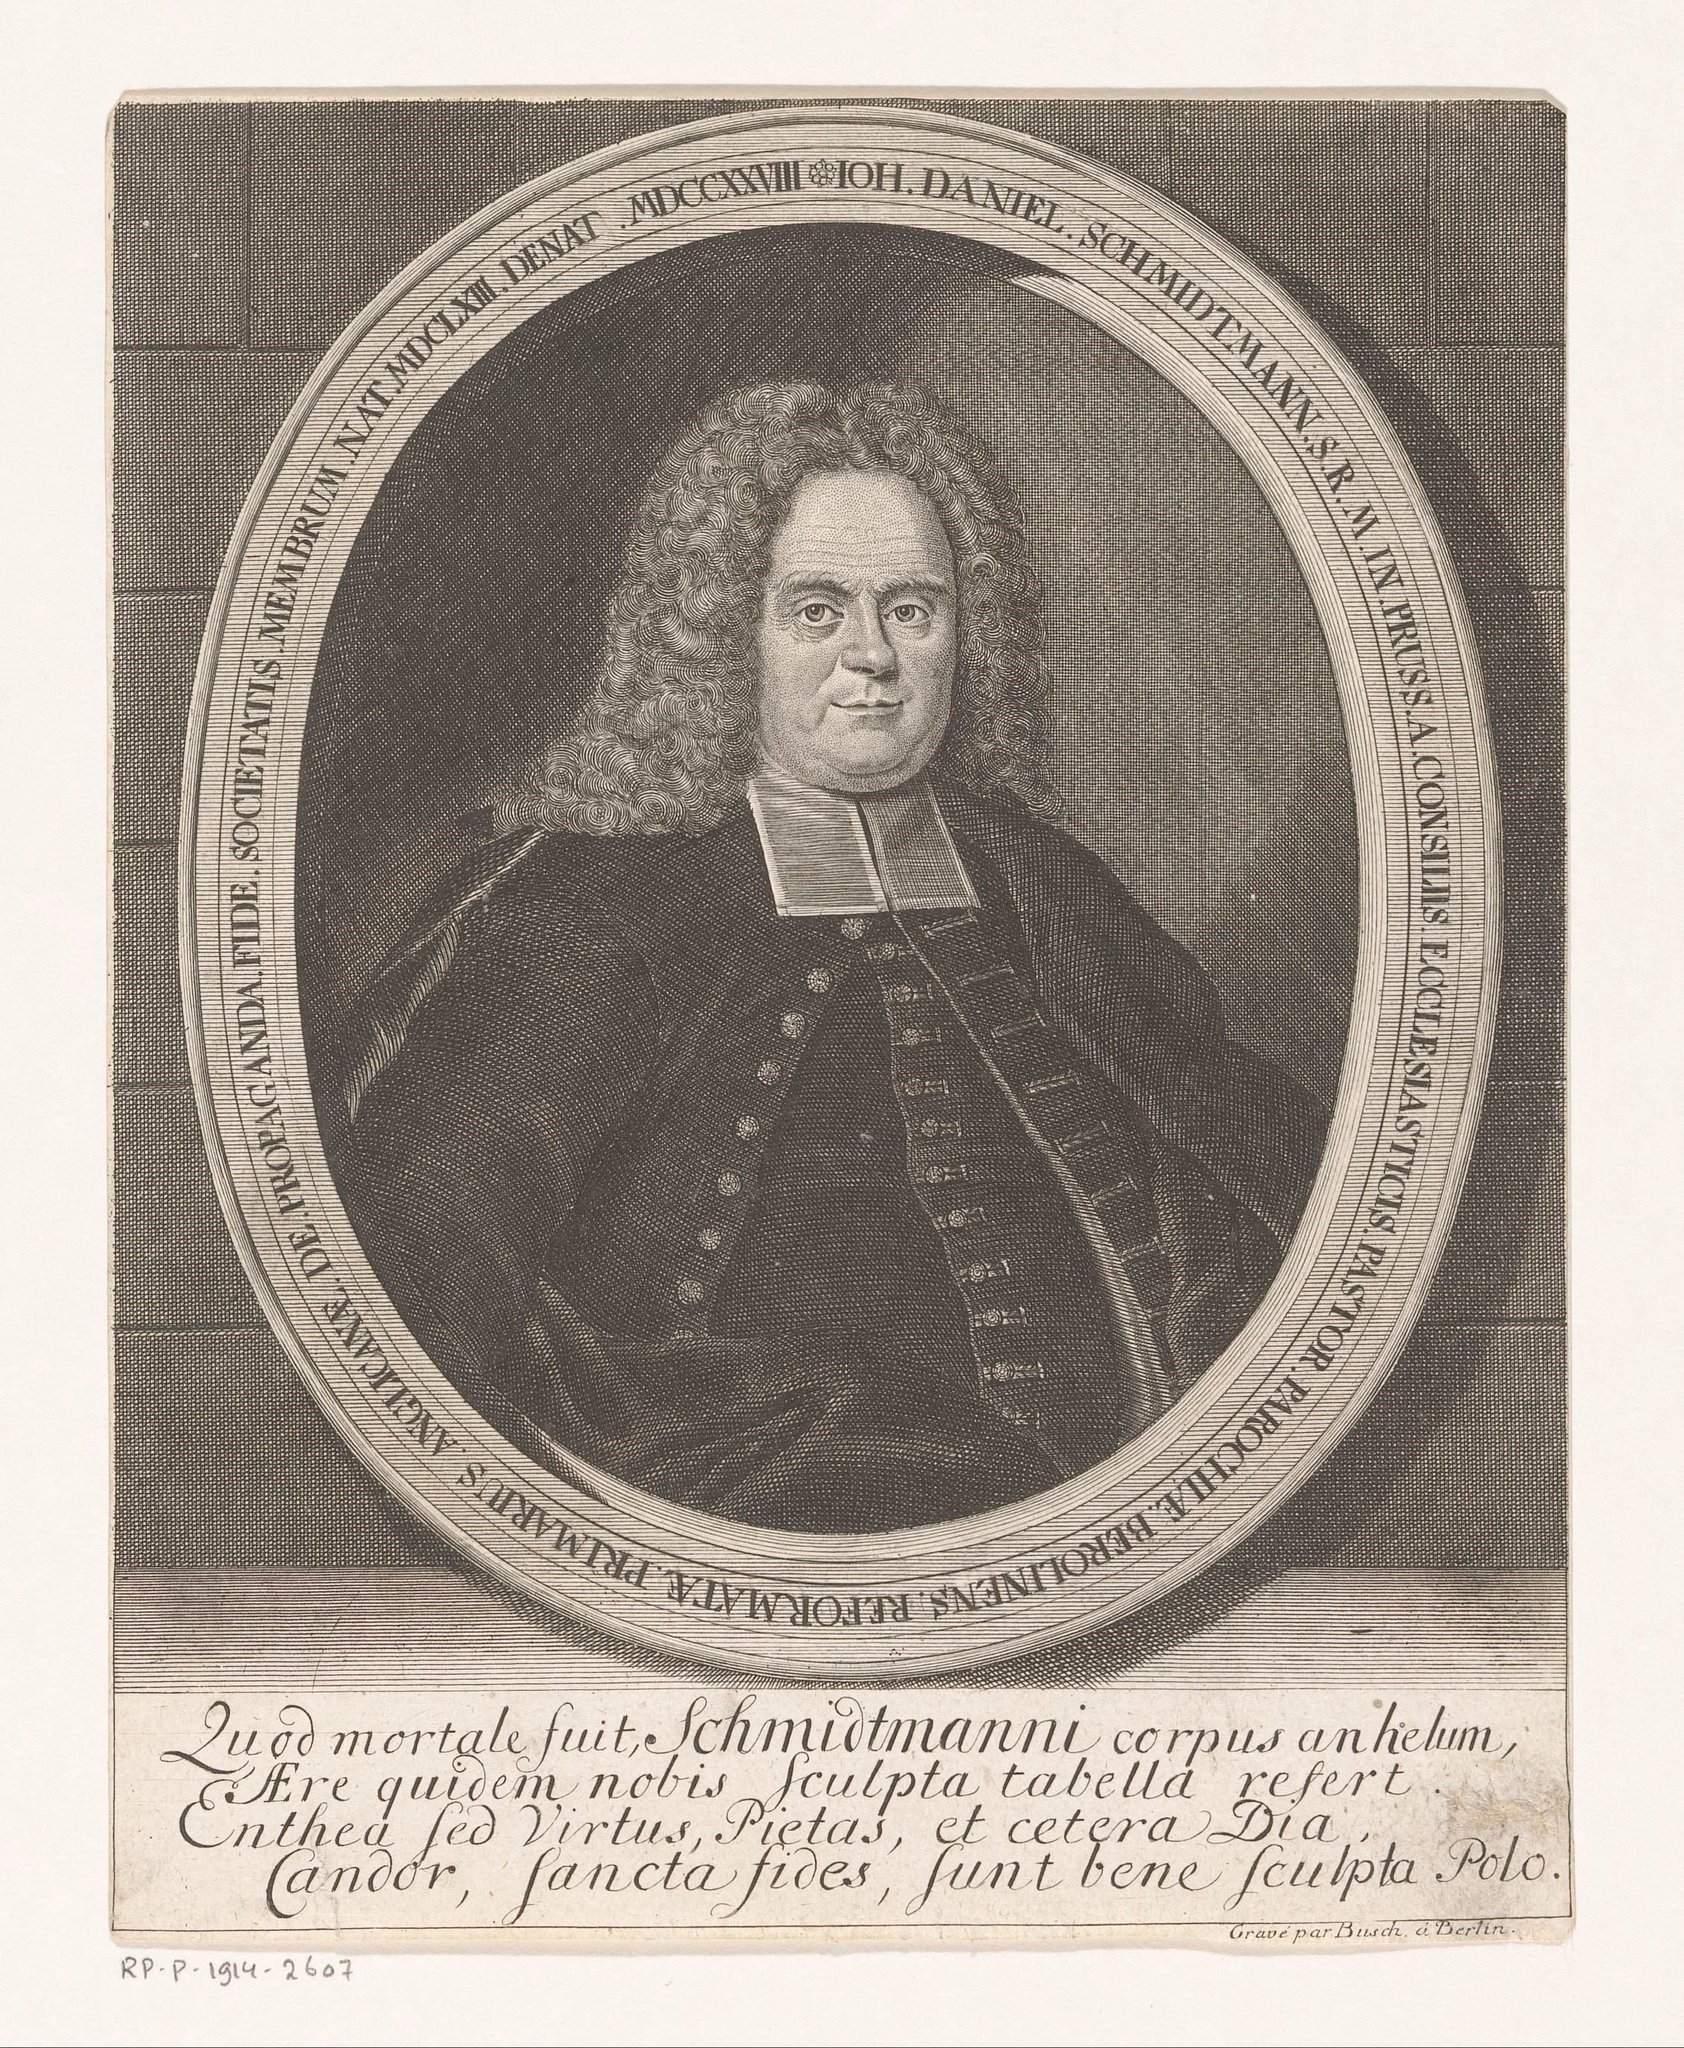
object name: print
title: Portret van Johann Daniel Schmidtmann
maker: georg paul busch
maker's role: print maker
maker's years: -1756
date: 1728-1756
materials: paper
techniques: engraving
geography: berlin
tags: berlin, historical persons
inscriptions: collector's mark: Lugt 2228